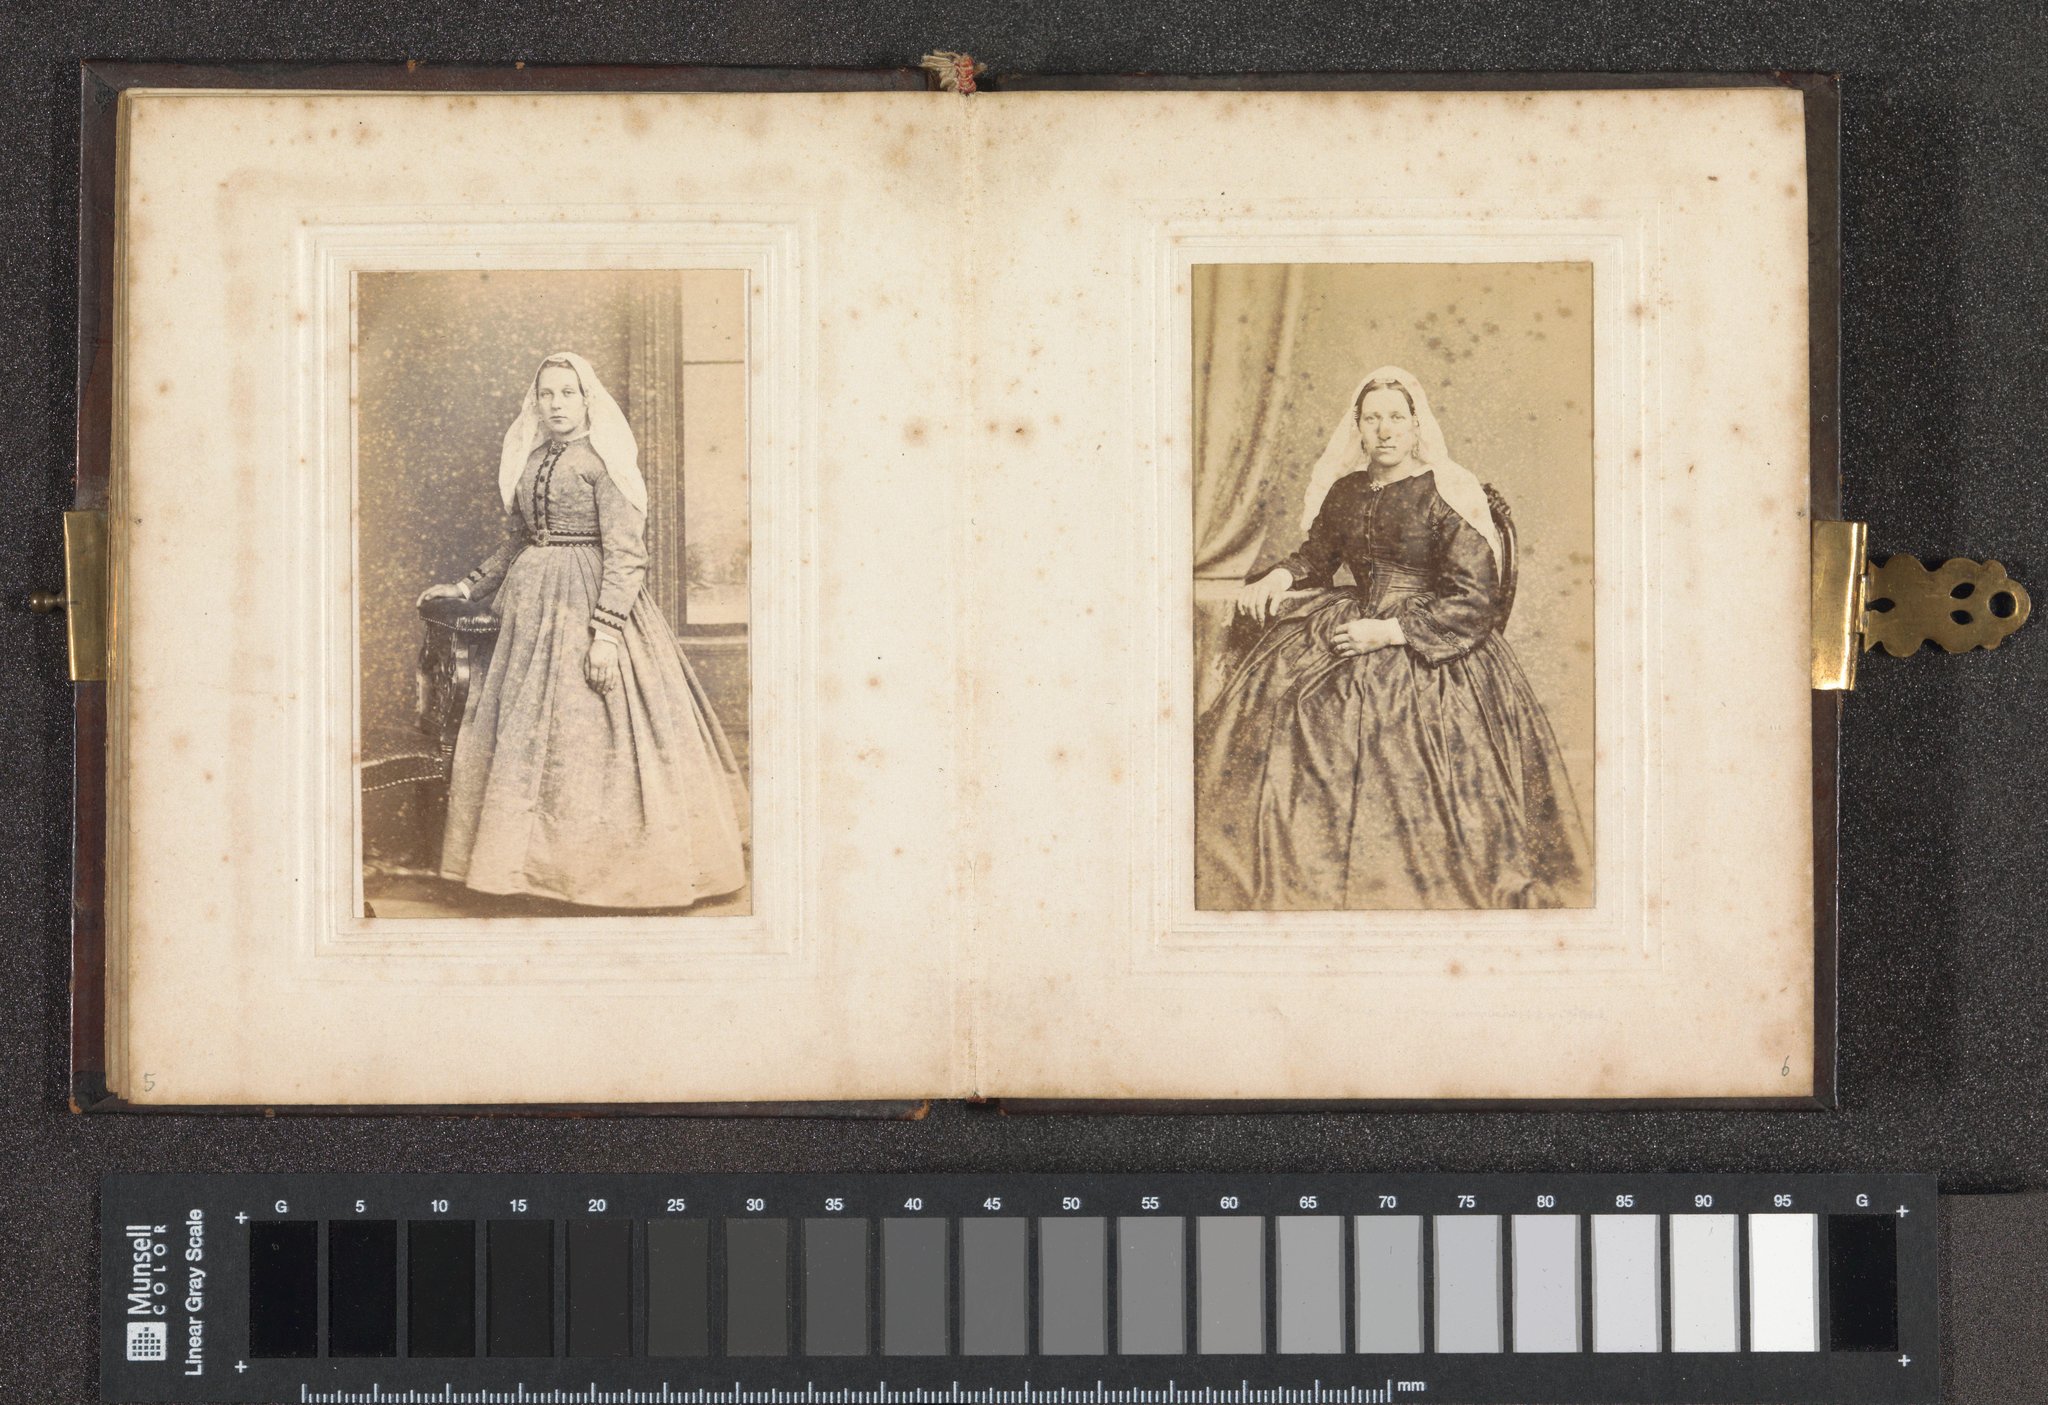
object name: carte de visite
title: Portret van een vrouw met een sluiermuts, zittend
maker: c. j. korsten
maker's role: painter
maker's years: 1829-1914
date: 1860-1875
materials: cardboard, paper, photographic support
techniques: albumen print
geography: zierikzee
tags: folk costume, regional costume (+ women's clothes), adult woman, studio requisites ~ photographer, historical persons, family life, head-gear: cap, dress, gown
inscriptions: address: ‘Zierikzee’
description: Onderdeel van Fotoalbum met cartes-de-visite van een Zeeuwse familie.